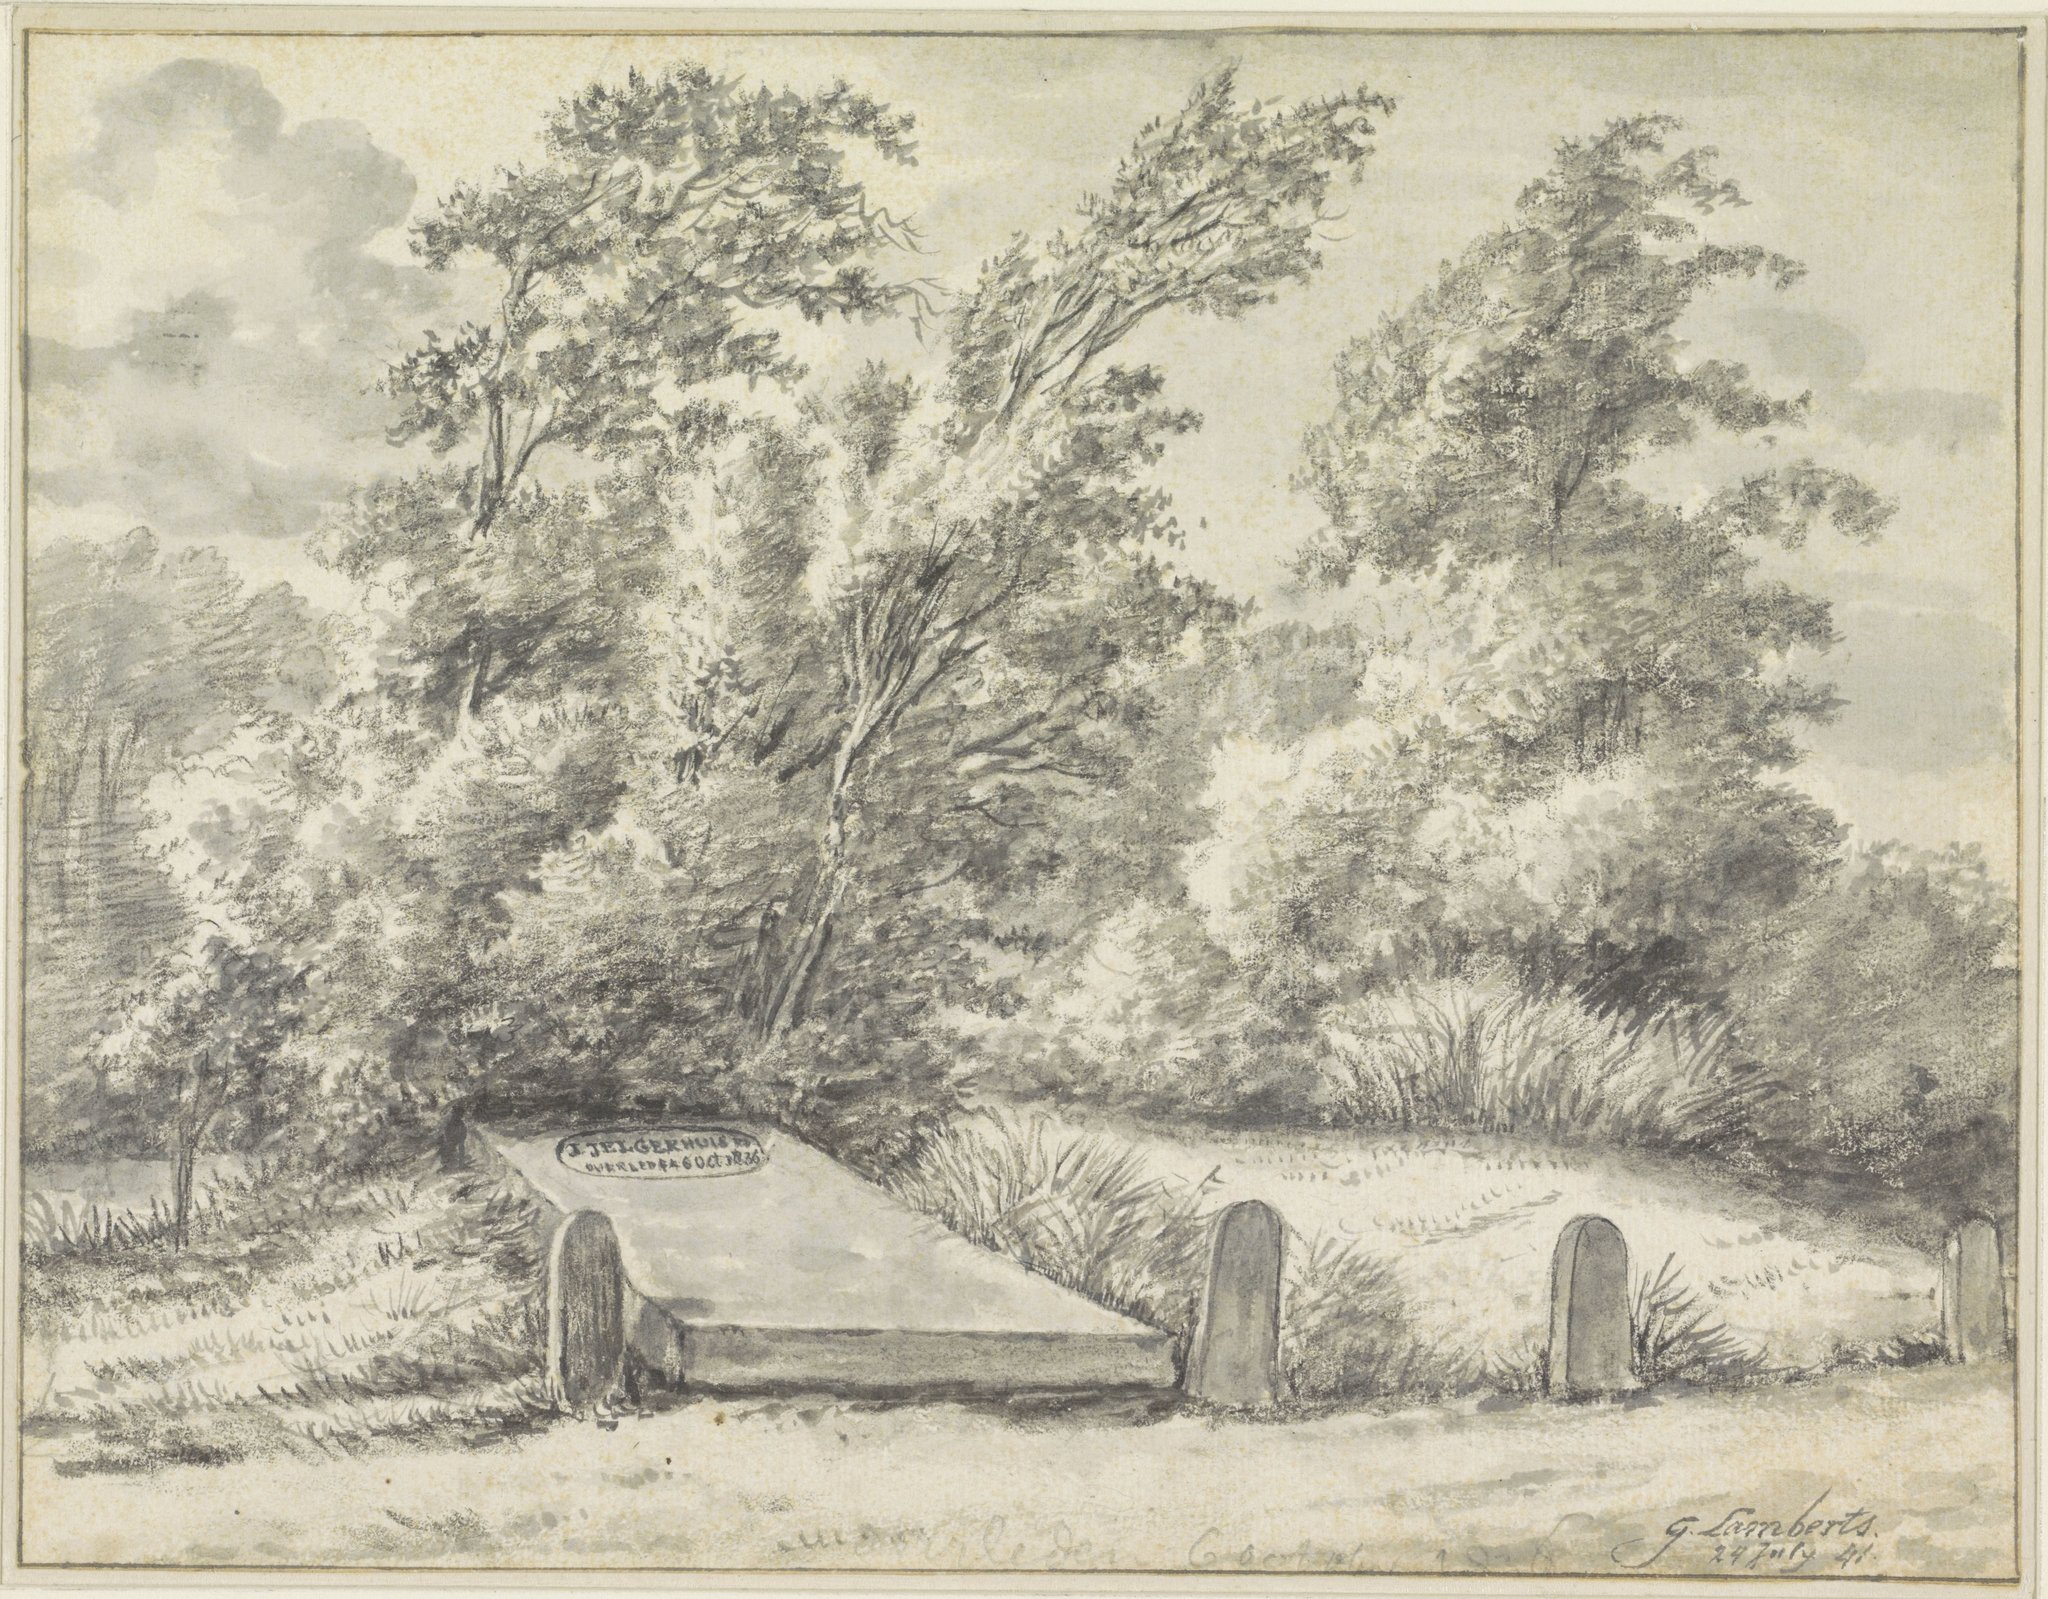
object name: drawing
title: Graf van Johannes Jelgerhuis Rienksz.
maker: gerrit lamberts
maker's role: bookseller, draughtsman, print maker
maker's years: 1776-1850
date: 1841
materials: chalk, paper, watercolor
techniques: brush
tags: painter, johannes jelgerhuis, upright gravestone, historical persons, grave, tomb, flat, horizontal gravestone